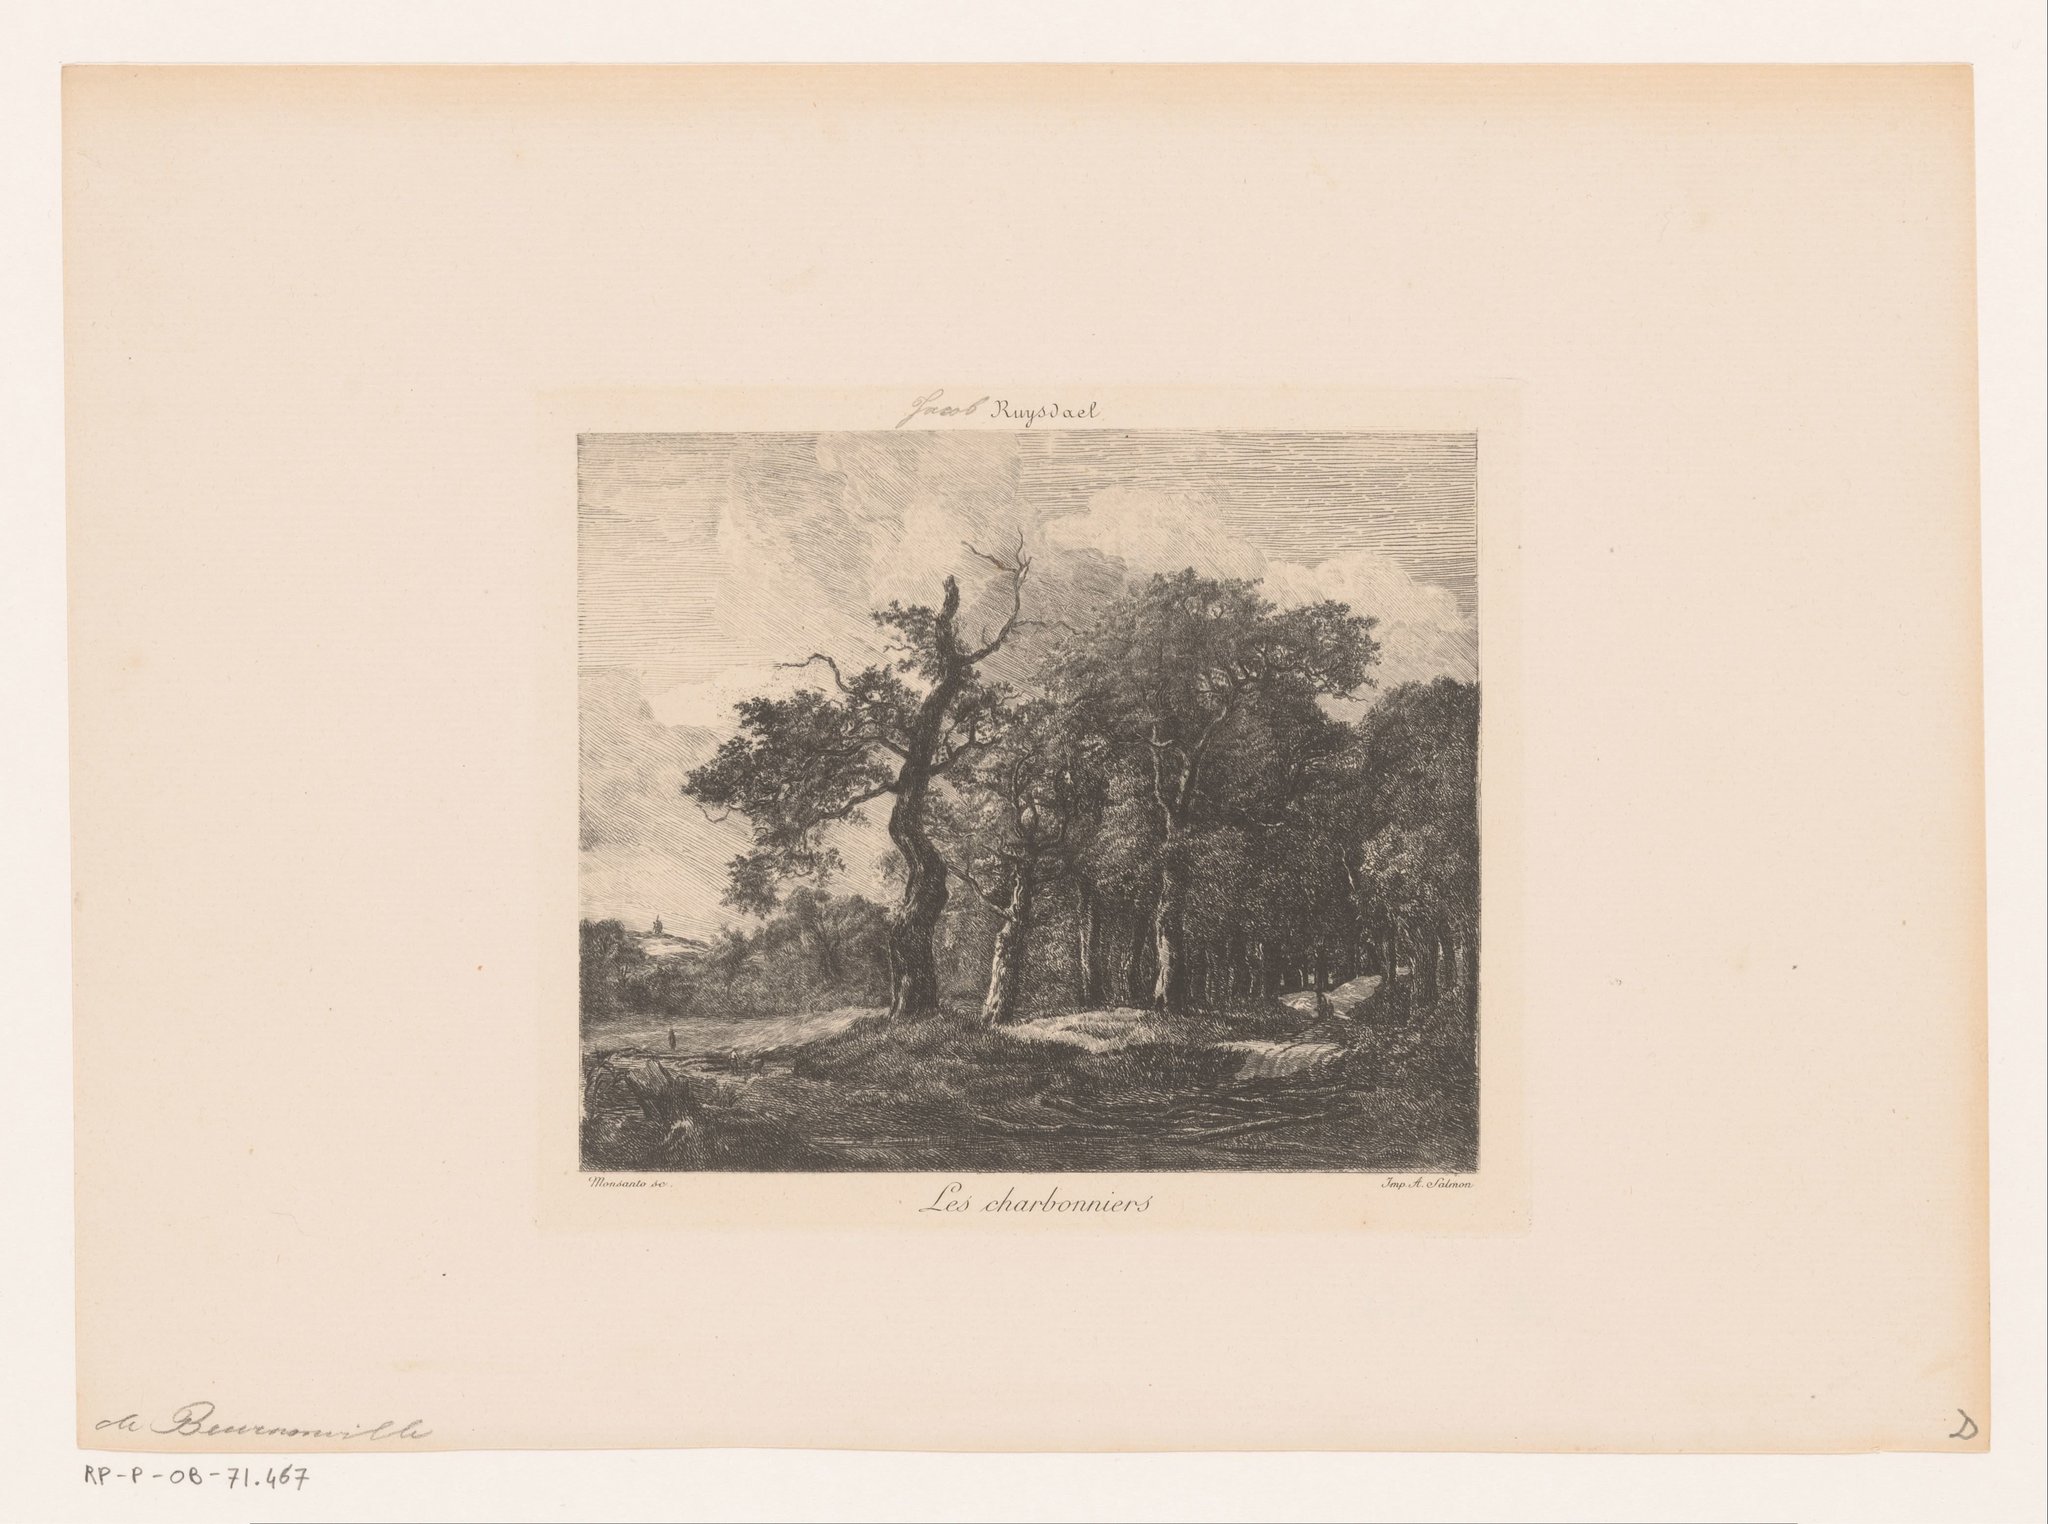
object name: print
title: Les charbonniers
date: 1881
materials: paper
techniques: etching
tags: woodcutting, woodcutter ~ forestry, forest, wood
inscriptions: collector's mark: Lugt 2228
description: Prent afkomstig uit een veilingcatalogus: "Catalogue des Tableaux anciens composant la très importante collection de Monsieur le Baron de Beurnonville", uitgegeven in 1881 te Parijs door Pillet en Dumoulin. De veiling vond plaats op 9 tot en met 14 en 16 mei 1881.